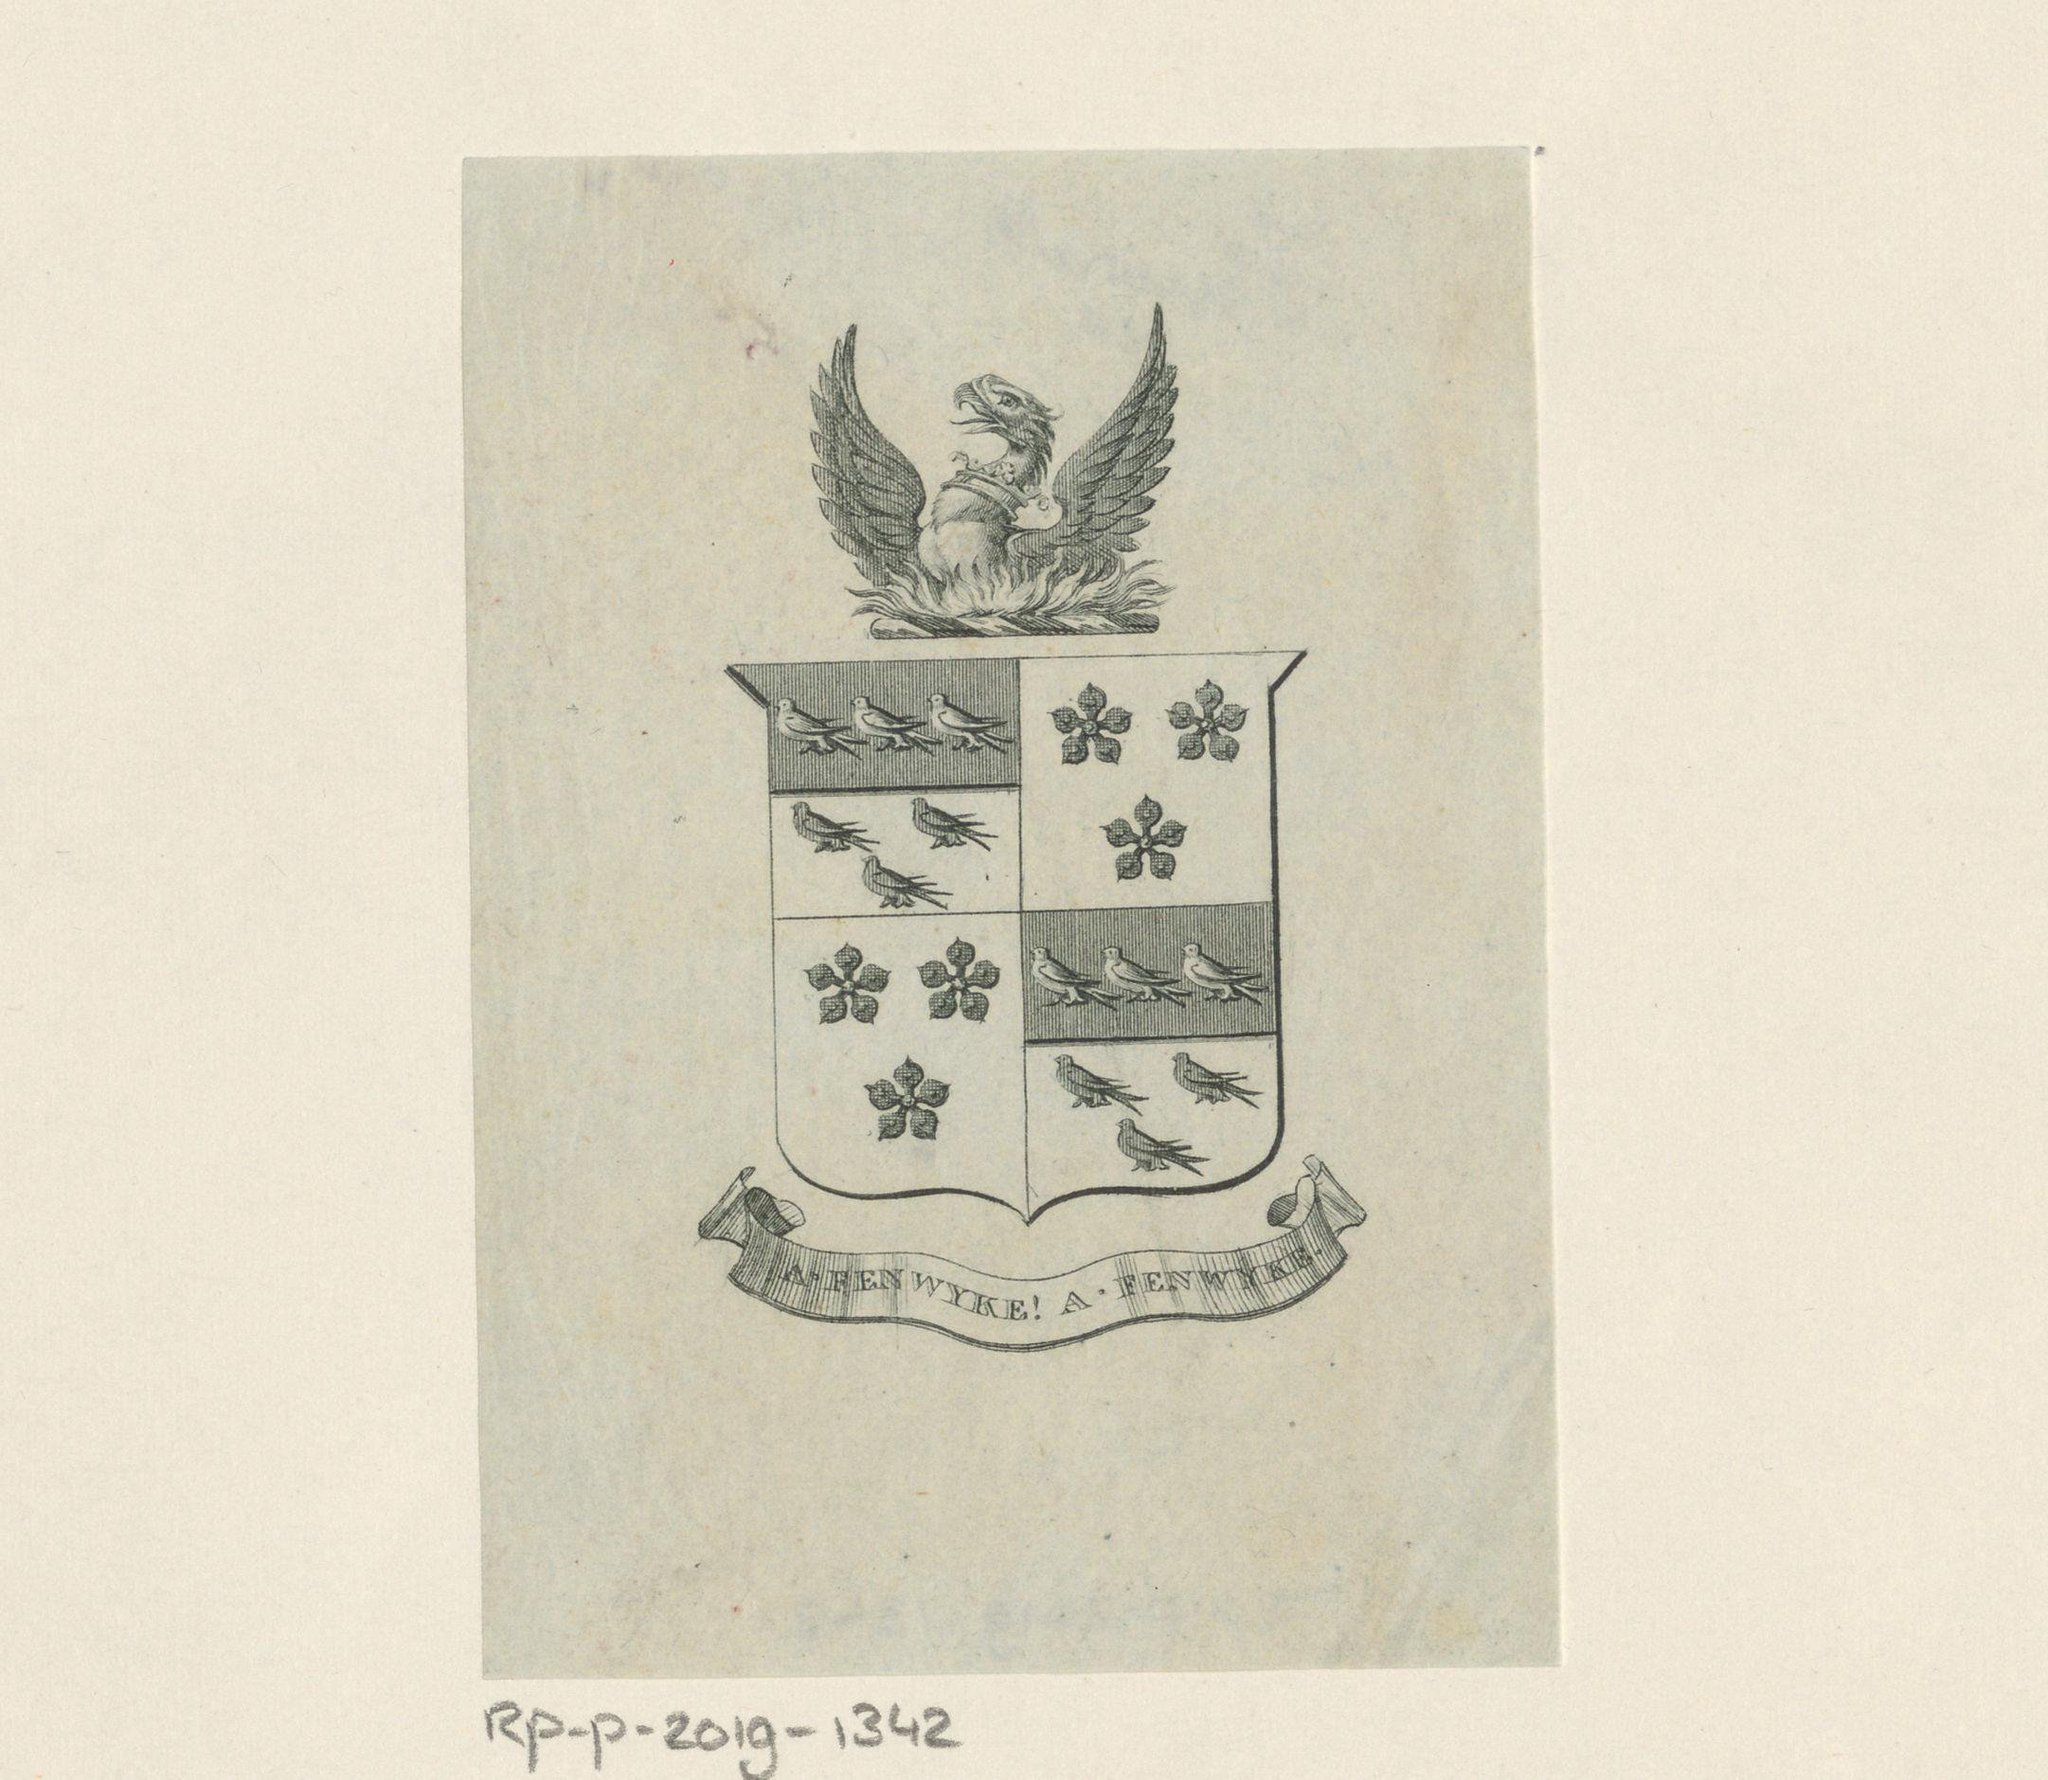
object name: bookplate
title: Ex libris van R.C. Fenwyke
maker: Anonymous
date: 1800-1899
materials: paper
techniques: engraving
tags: armorial bearing, heraldry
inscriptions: collector's mark: Lugt 704, collector's mark: Lugt 344